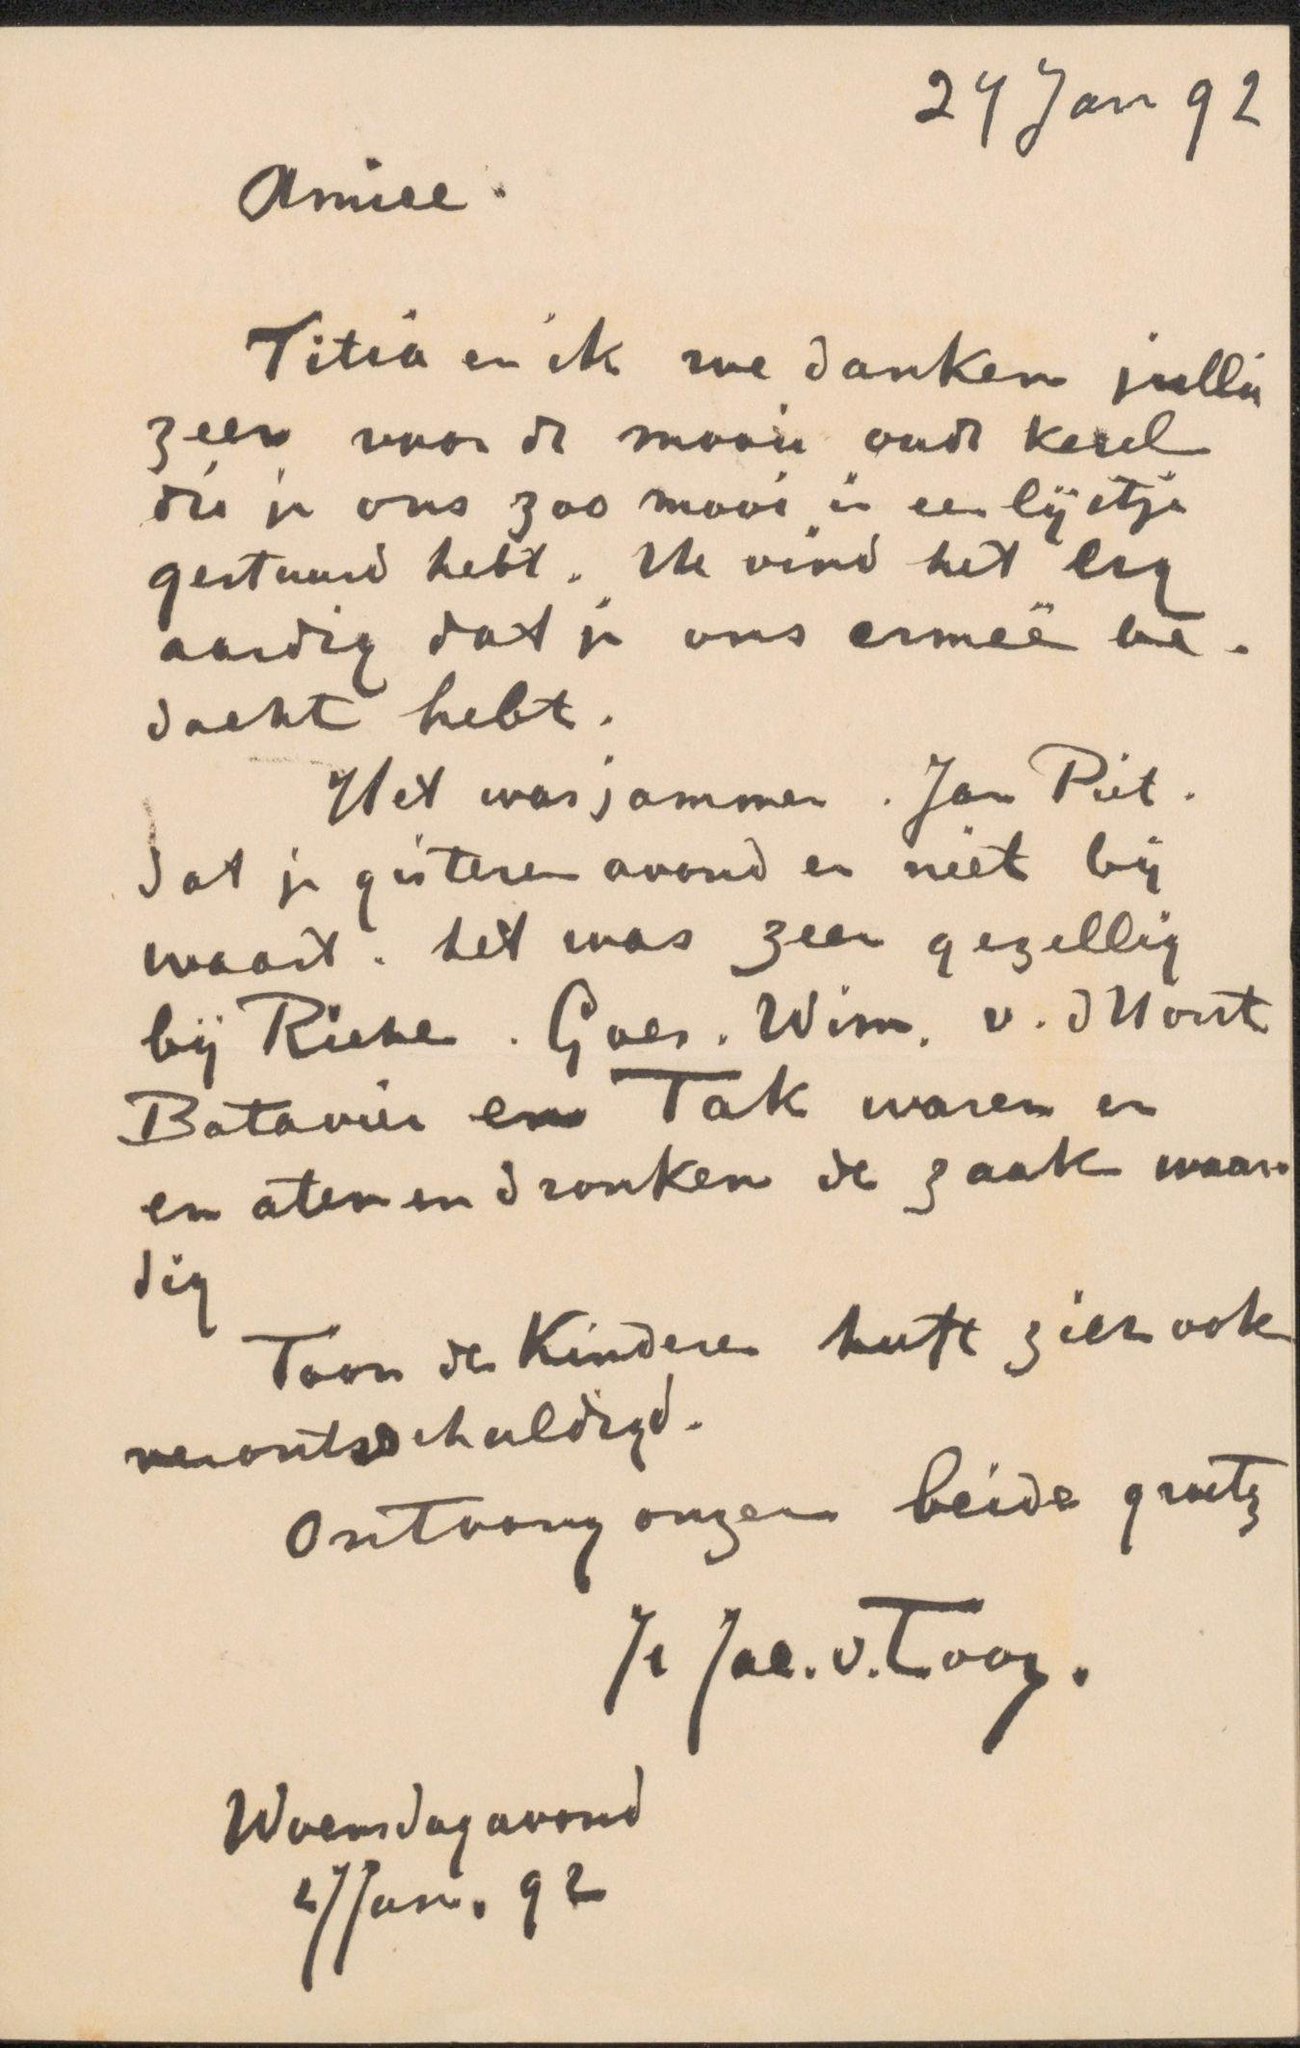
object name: letter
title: Brief aan Jan Veth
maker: jac van looij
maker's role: draughtsman, painter, print maker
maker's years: 1855-1930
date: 1892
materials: ink, paper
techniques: pen, writing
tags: jan veth, den bosch, antoon derkinderen, amsterdam, willem witsen, frank van der goes, politician, pieter lodewijk tak, historical persons (portraits and scenes from the life)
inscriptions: watermark, collector's mark: ‘RPK’